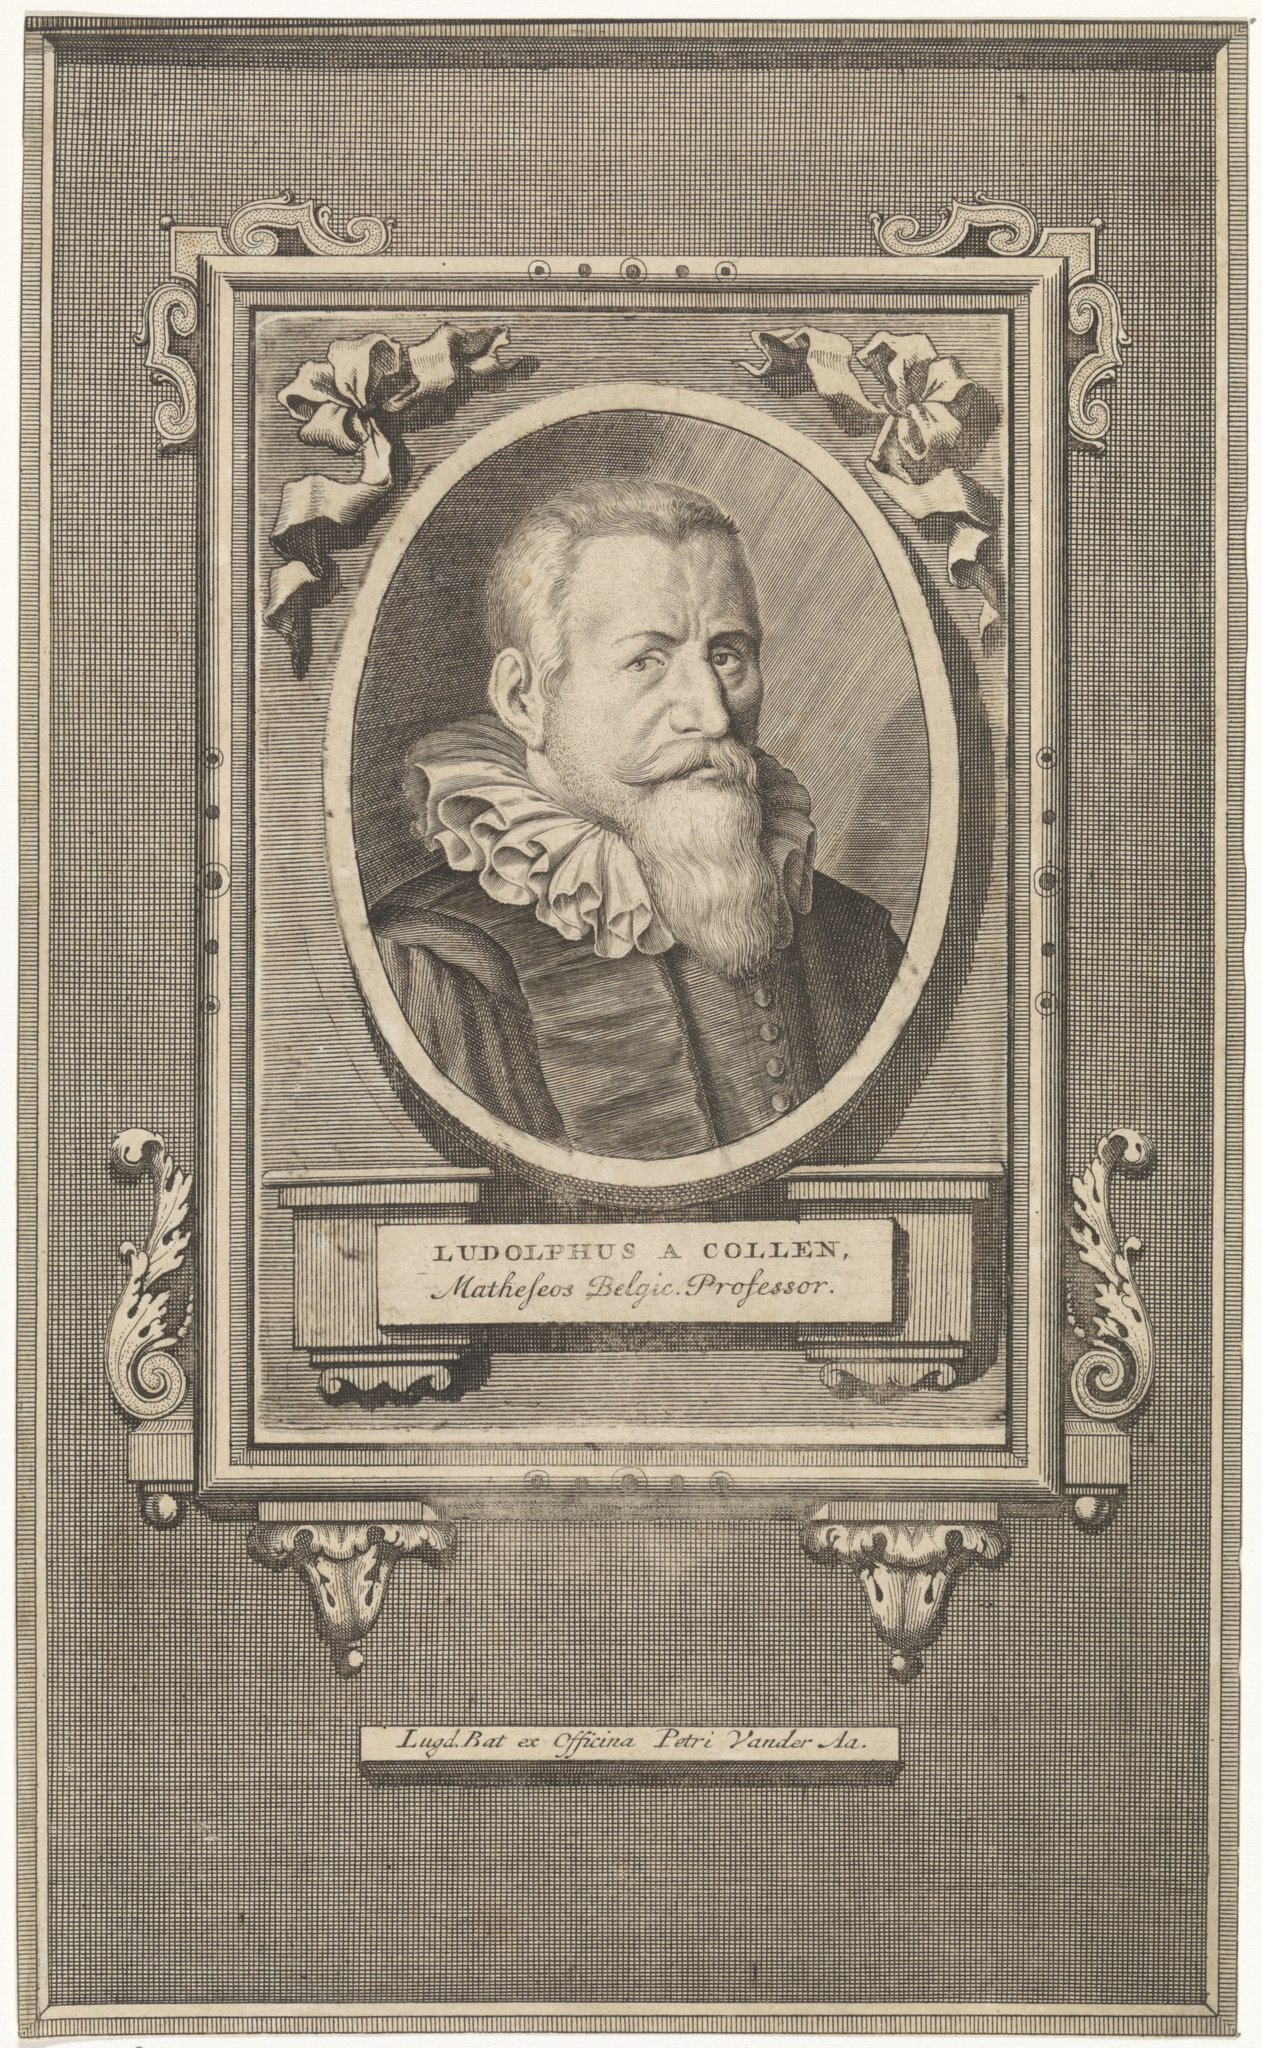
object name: print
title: Portret van Ludolph van Ceulen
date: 1625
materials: paper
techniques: engraving, etching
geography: leiden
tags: leiden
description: Prent ook gebruikt als boekillustratie in: Meursius, Joannes. Athenæ Batavæ. Sive, De vrbe Leidensi, & academiâ, virisque claris. Leiden: Andries Clouck, Bonaventura en Abraham Elzevier, 1625.